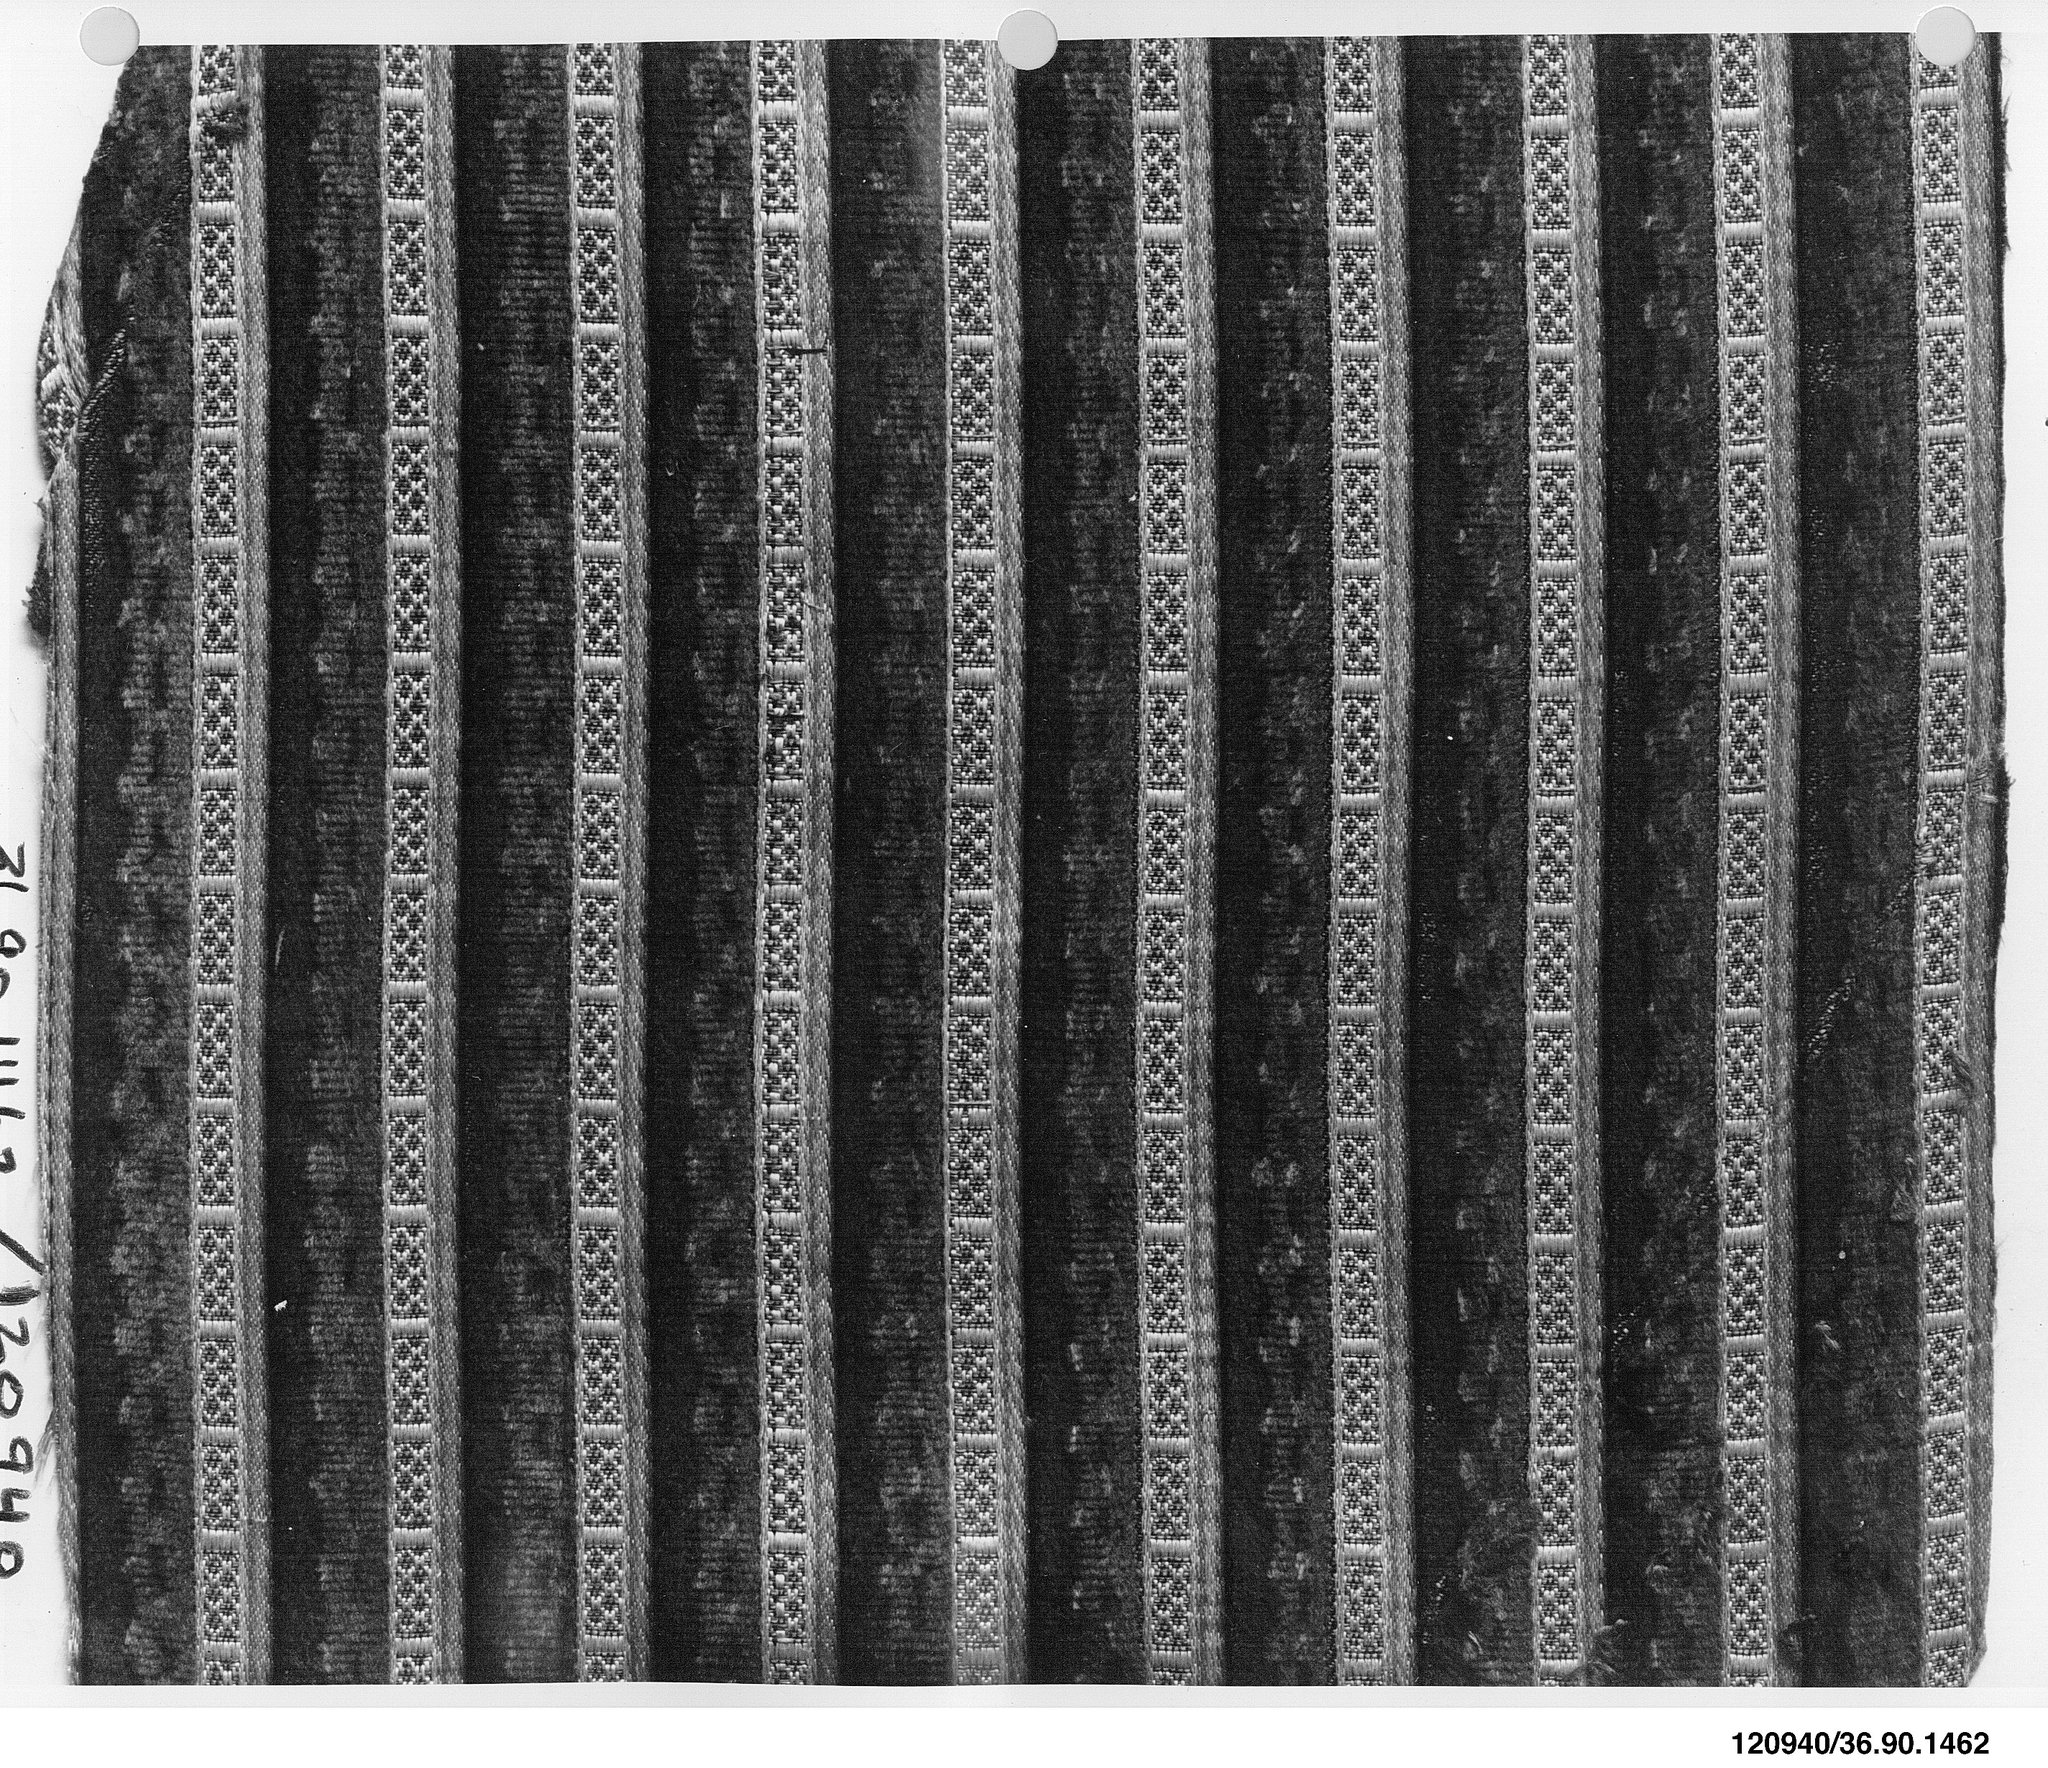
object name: piece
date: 1701-1800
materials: silk